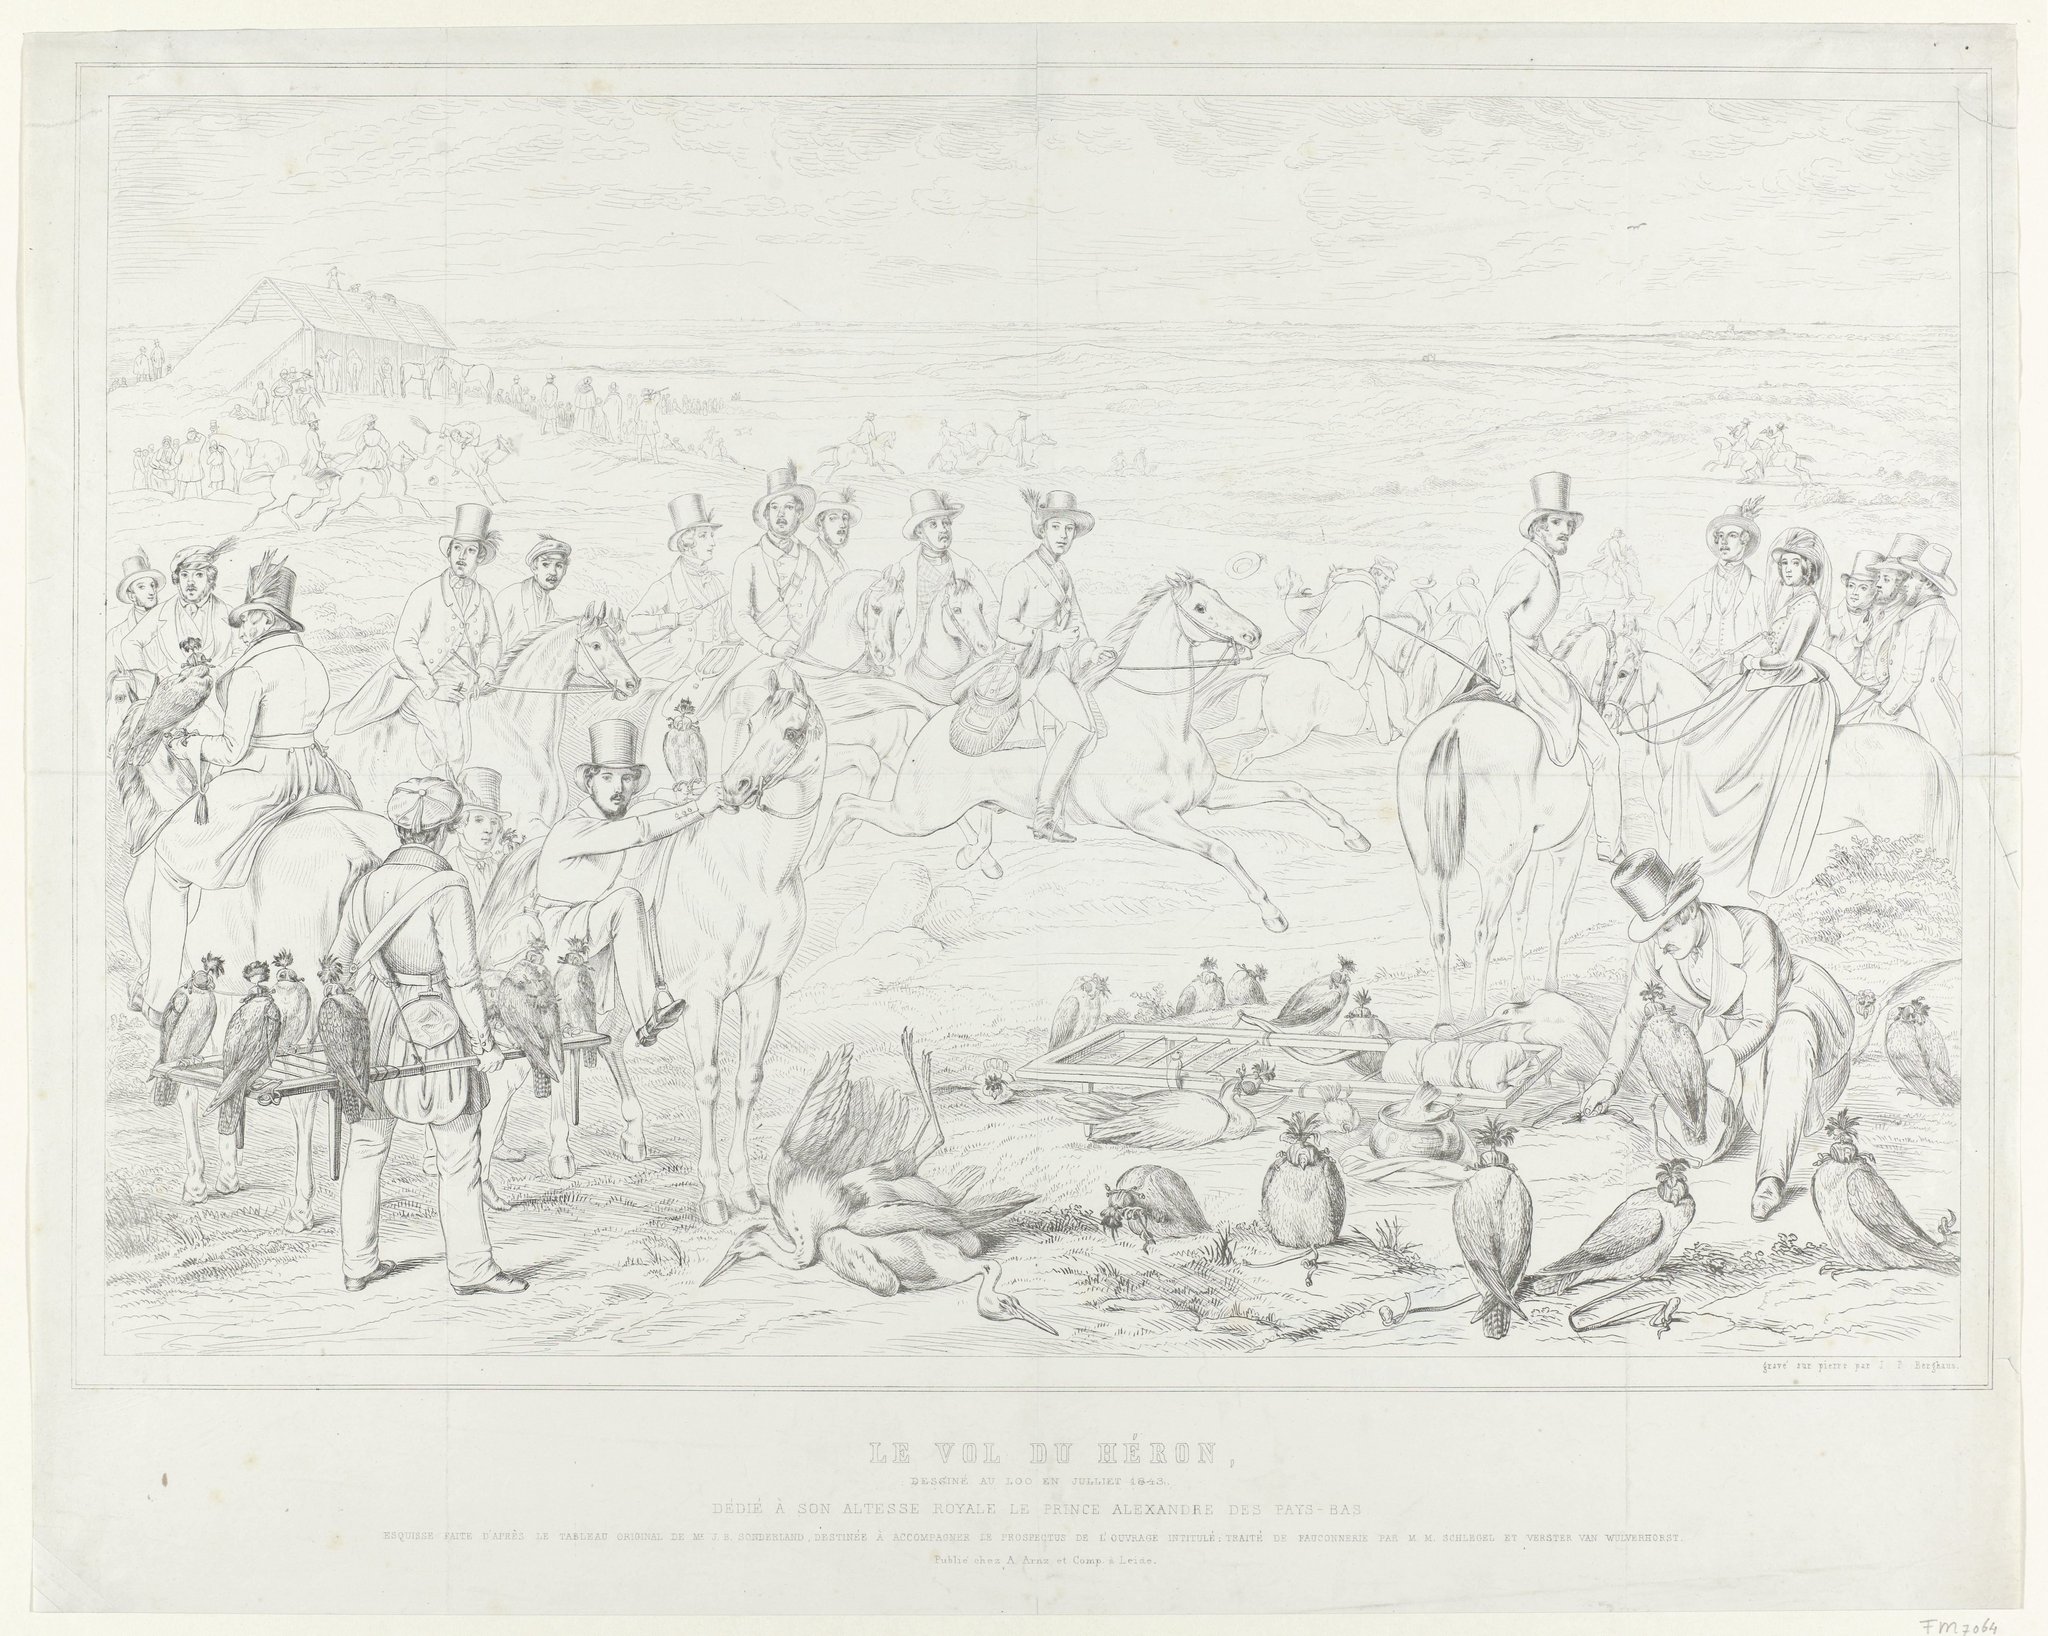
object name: print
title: Valkenjacht op reigers, 1843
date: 1844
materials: paper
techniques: lithograph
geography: netherlands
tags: alexander (prins der nederlanden, prins van oranje-nassau), predatory birds: falcon, shore-birds and wading-birds: heron, hunting, chase (+ hunting with falcon, hawk; falconry), netherlands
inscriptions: collector's mark: Lugt 2228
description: Valkenjacht gehouden in juli 1843 op de hei nabij Paleis Het Loo. Centraal te paard prins Alexander met zijn gevolg. Rechts kijkt het echtpaar Van Verschuer-Brants, eveneens leden van de Royal Loo Hawking Club, te paard toe. Links een man met een rek waarop meerdere valken zitten, vooraan enkele gevangen reigers. Prins Alexander was voorzitter van de Royal Loo Hawking Club, twee andere leden, Fr. van den Heuvel en Adriaan Mollen zijn links geportretteerd. Behoort bij de prospectus voor een reeks van zeventien platen over de valkenjacht, het eerste deel te verschijnen in oktober 1844, als proeve van illustratie.